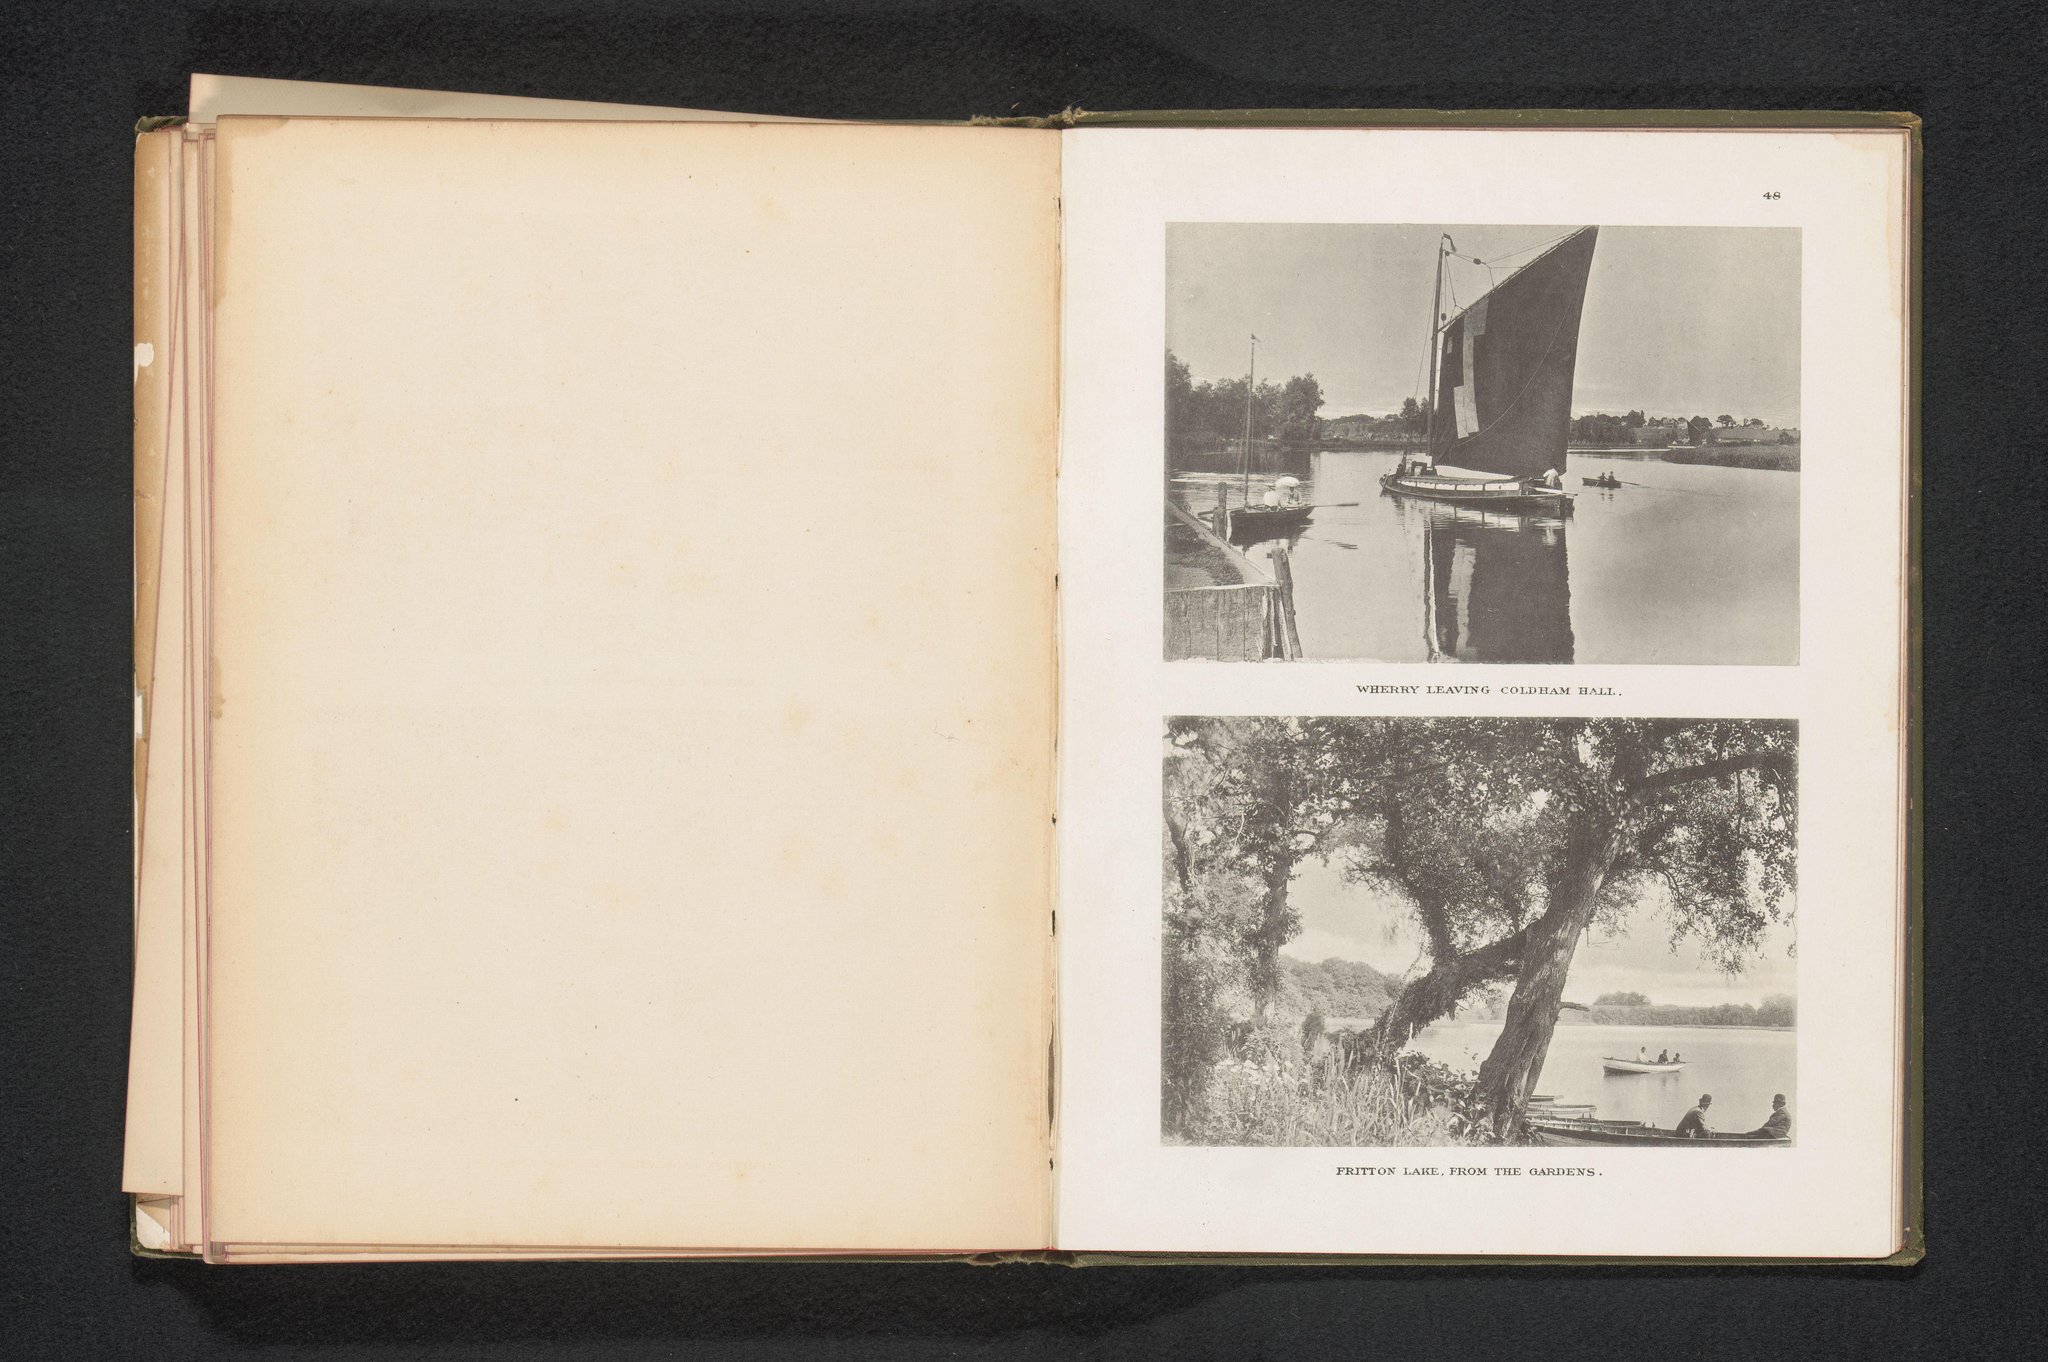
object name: photomechanical print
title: Wherry leaving Coldham Hall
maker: john payne jennings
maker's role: fotograaf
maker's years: 1843-1926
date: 1886-1891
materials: paper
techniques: photograph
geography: surlingham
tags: sailing-ship, sailing-boat, river